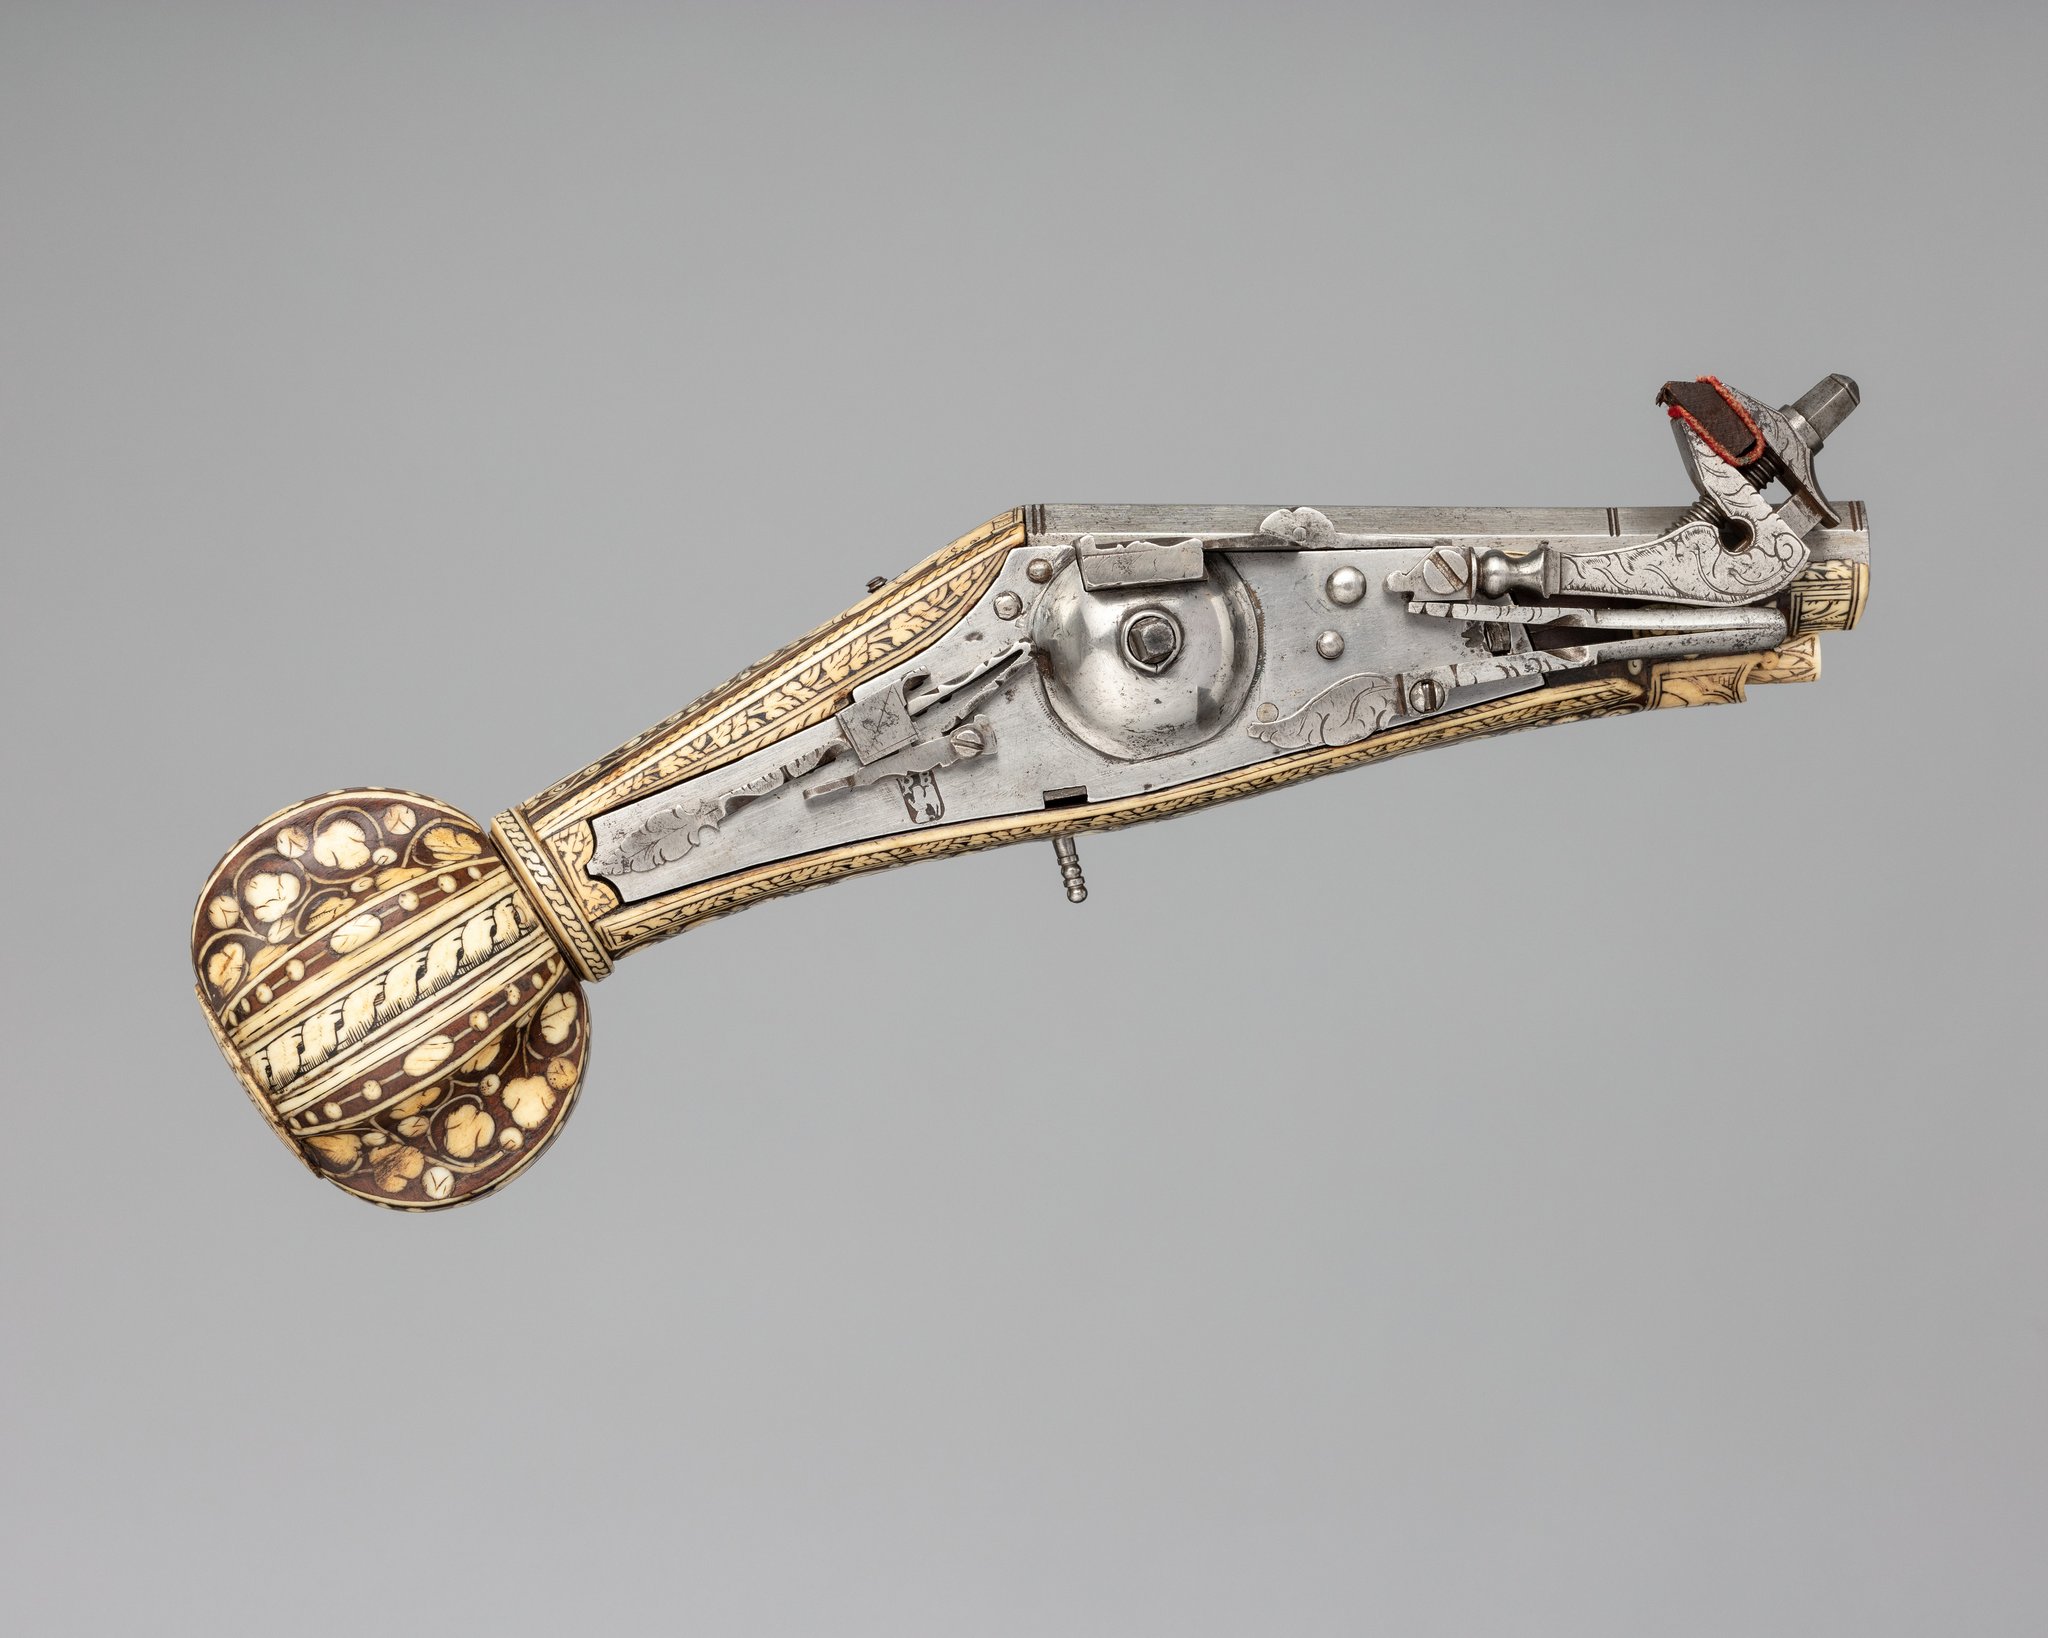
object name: wheellock pistol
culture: german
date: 1580-1590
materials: ivory, steel, wood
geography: germany